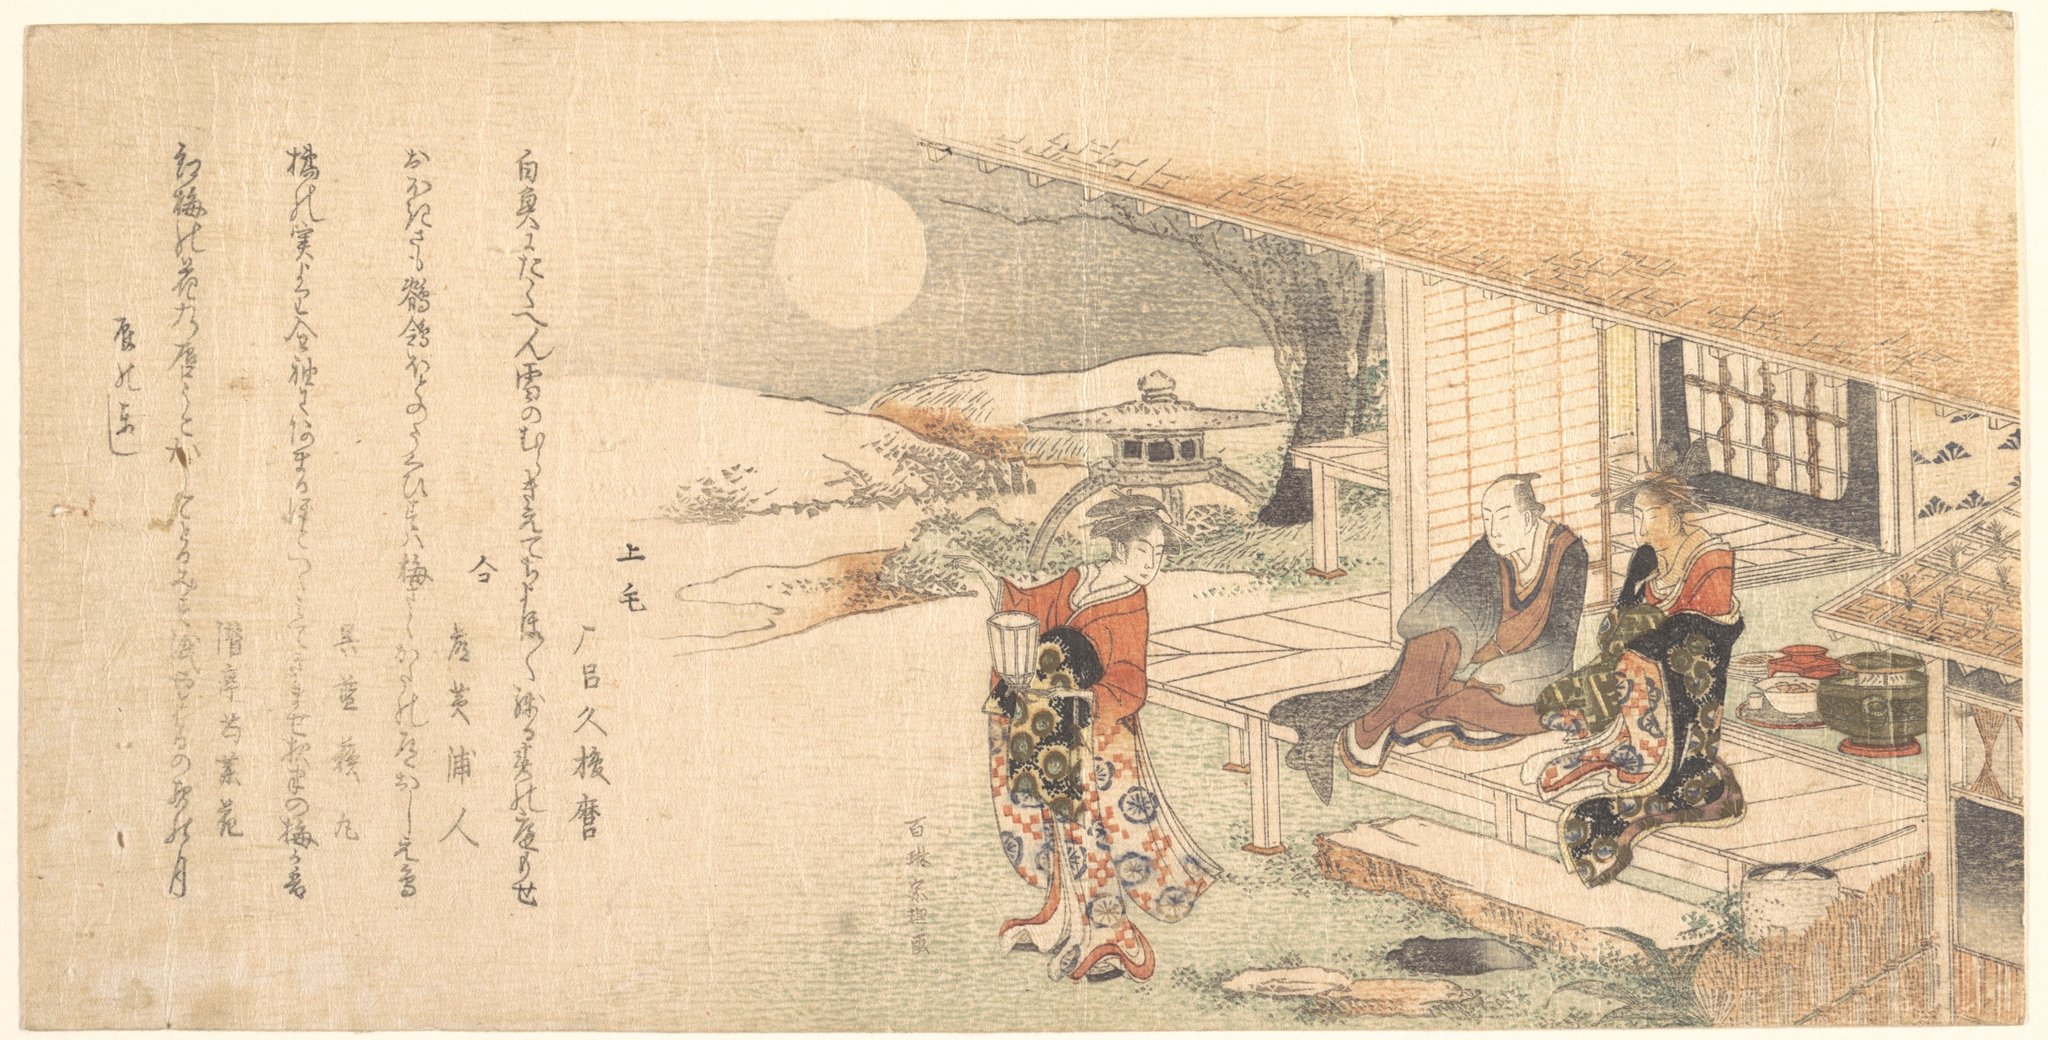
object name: print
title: Young Lady with Lamp; Man and Woman on Veranda of Tea-House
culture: japanese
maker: katsushika hokusai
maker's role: artist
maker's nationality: japanese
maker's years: 1760-1849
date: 1760-1849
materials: ink, paper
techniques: surimono, woodblock print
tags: men,women,tea houses